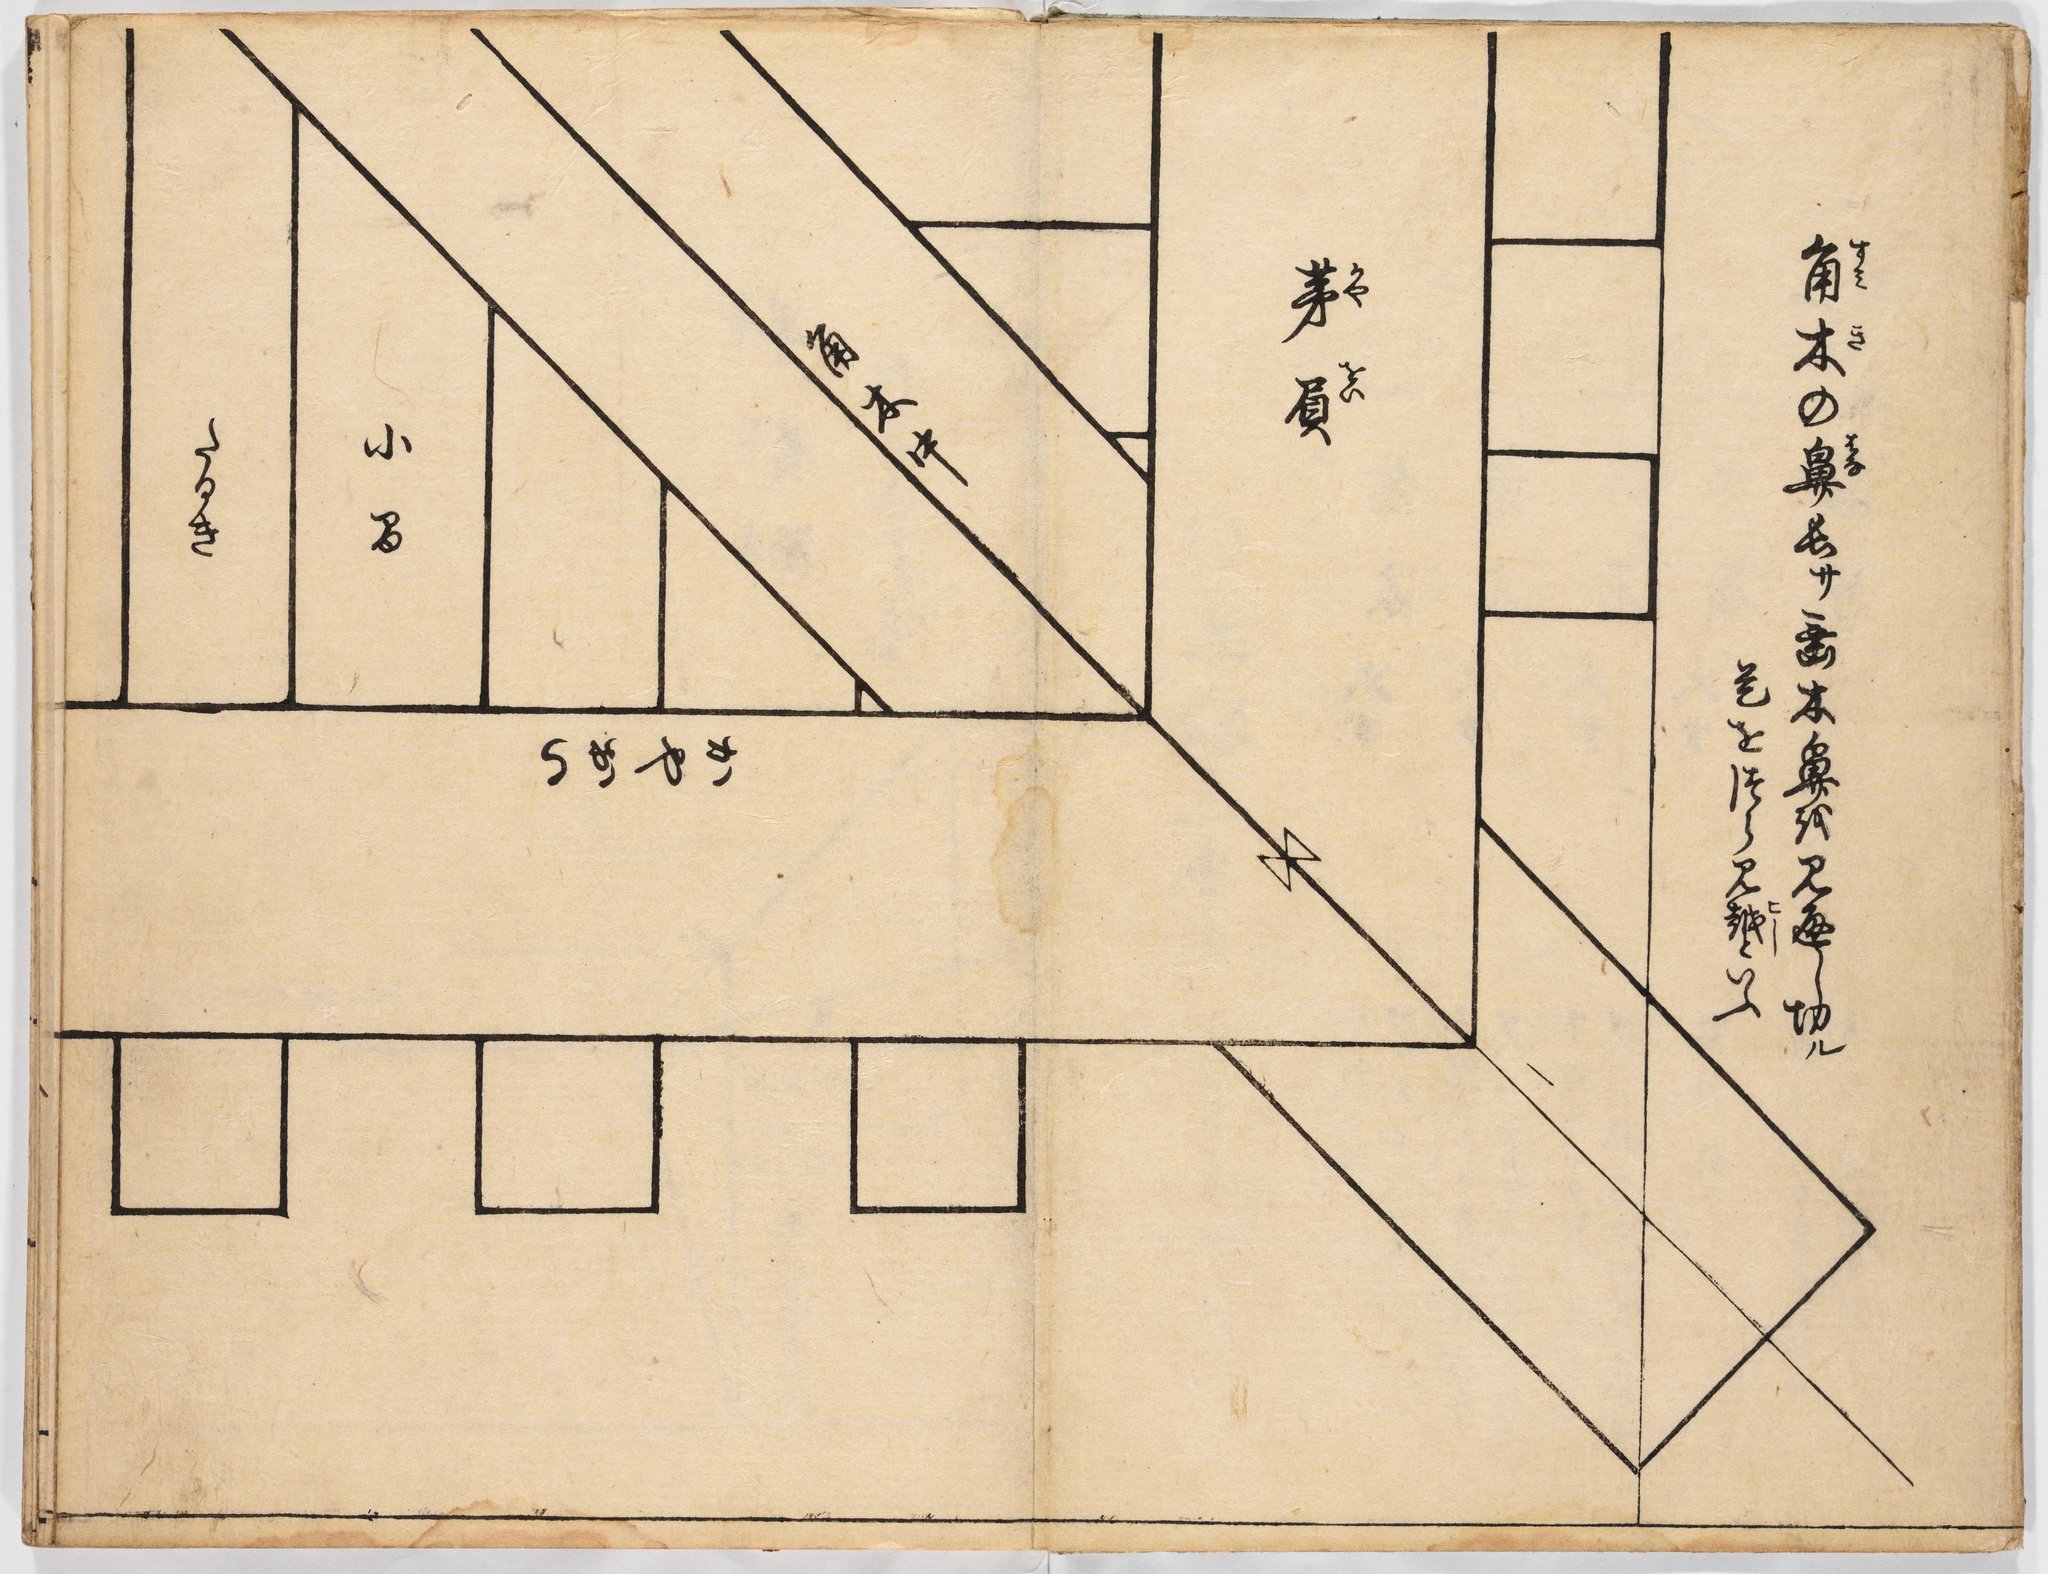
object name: illustrated book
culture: japanese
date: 1893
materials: ink, paper